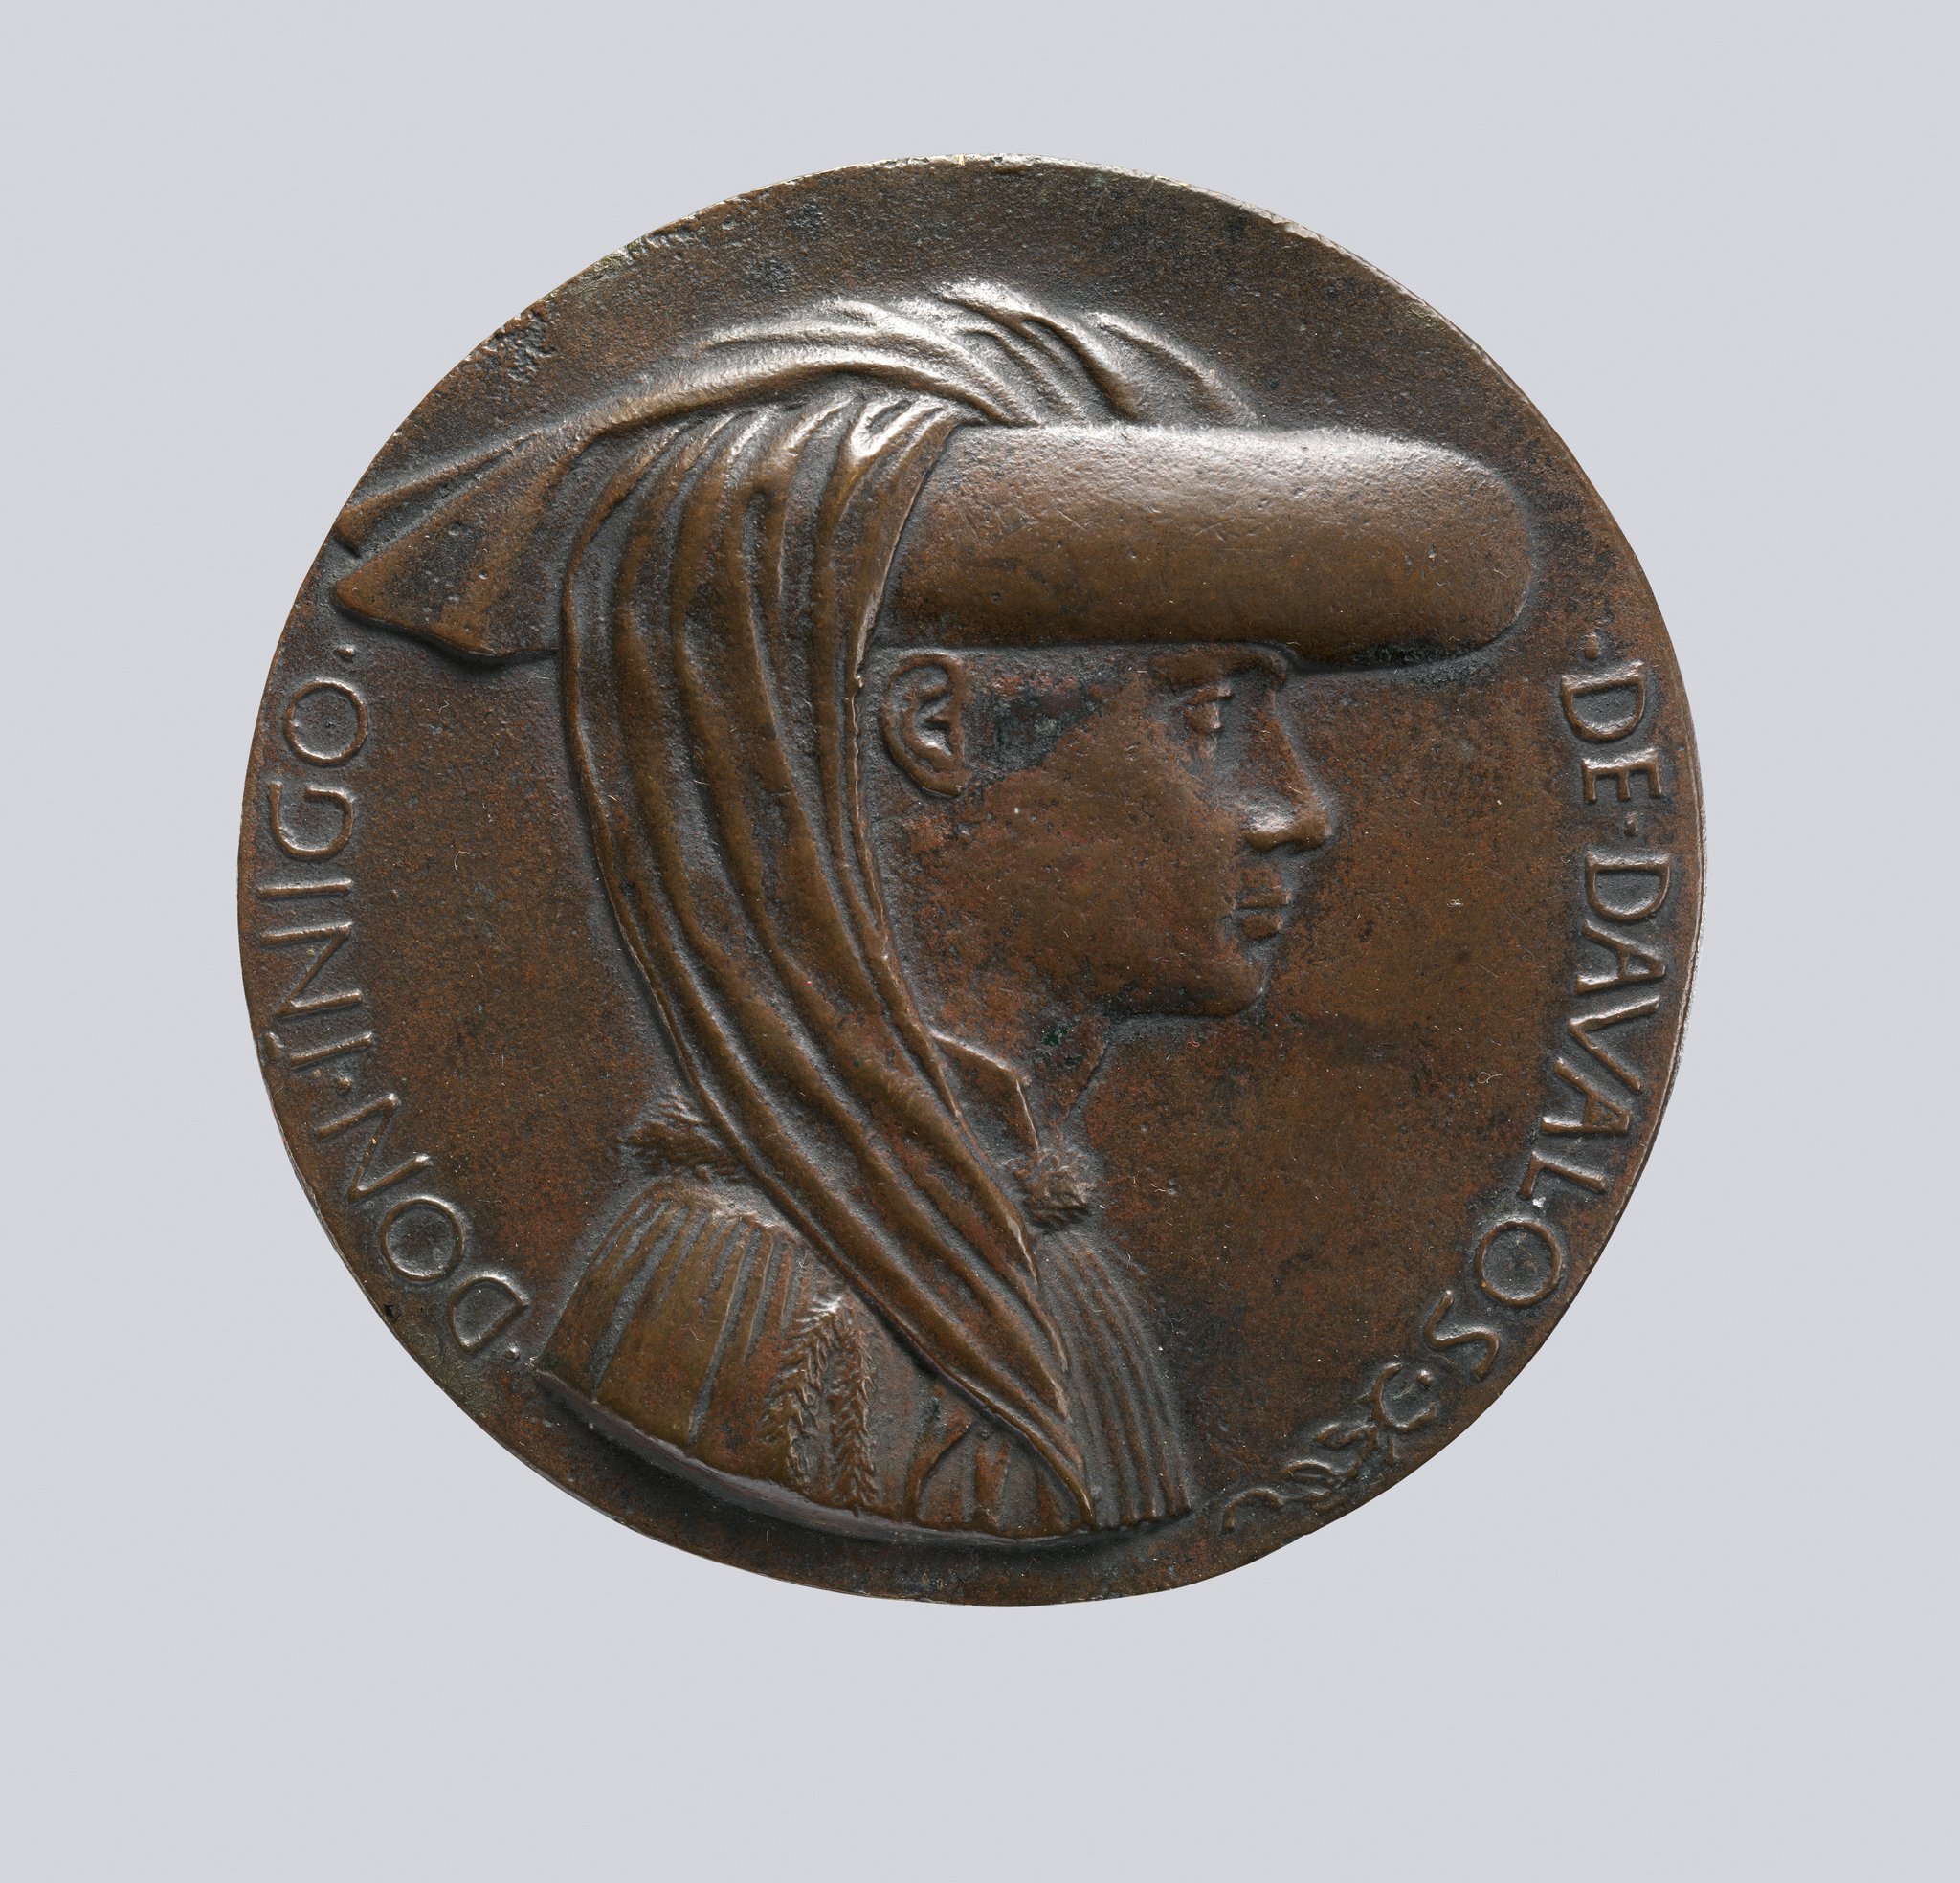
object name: medal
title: Portrait medal of Don Inigo d'Avalos (obverse); Sphere Representing Earth, Sea, and Sky (reverse)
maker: pisanello (antonio pisano)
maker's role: artist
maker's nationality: italian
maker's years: 1395-1455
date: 1449-1450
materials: bronze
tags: men,portraits,profiles